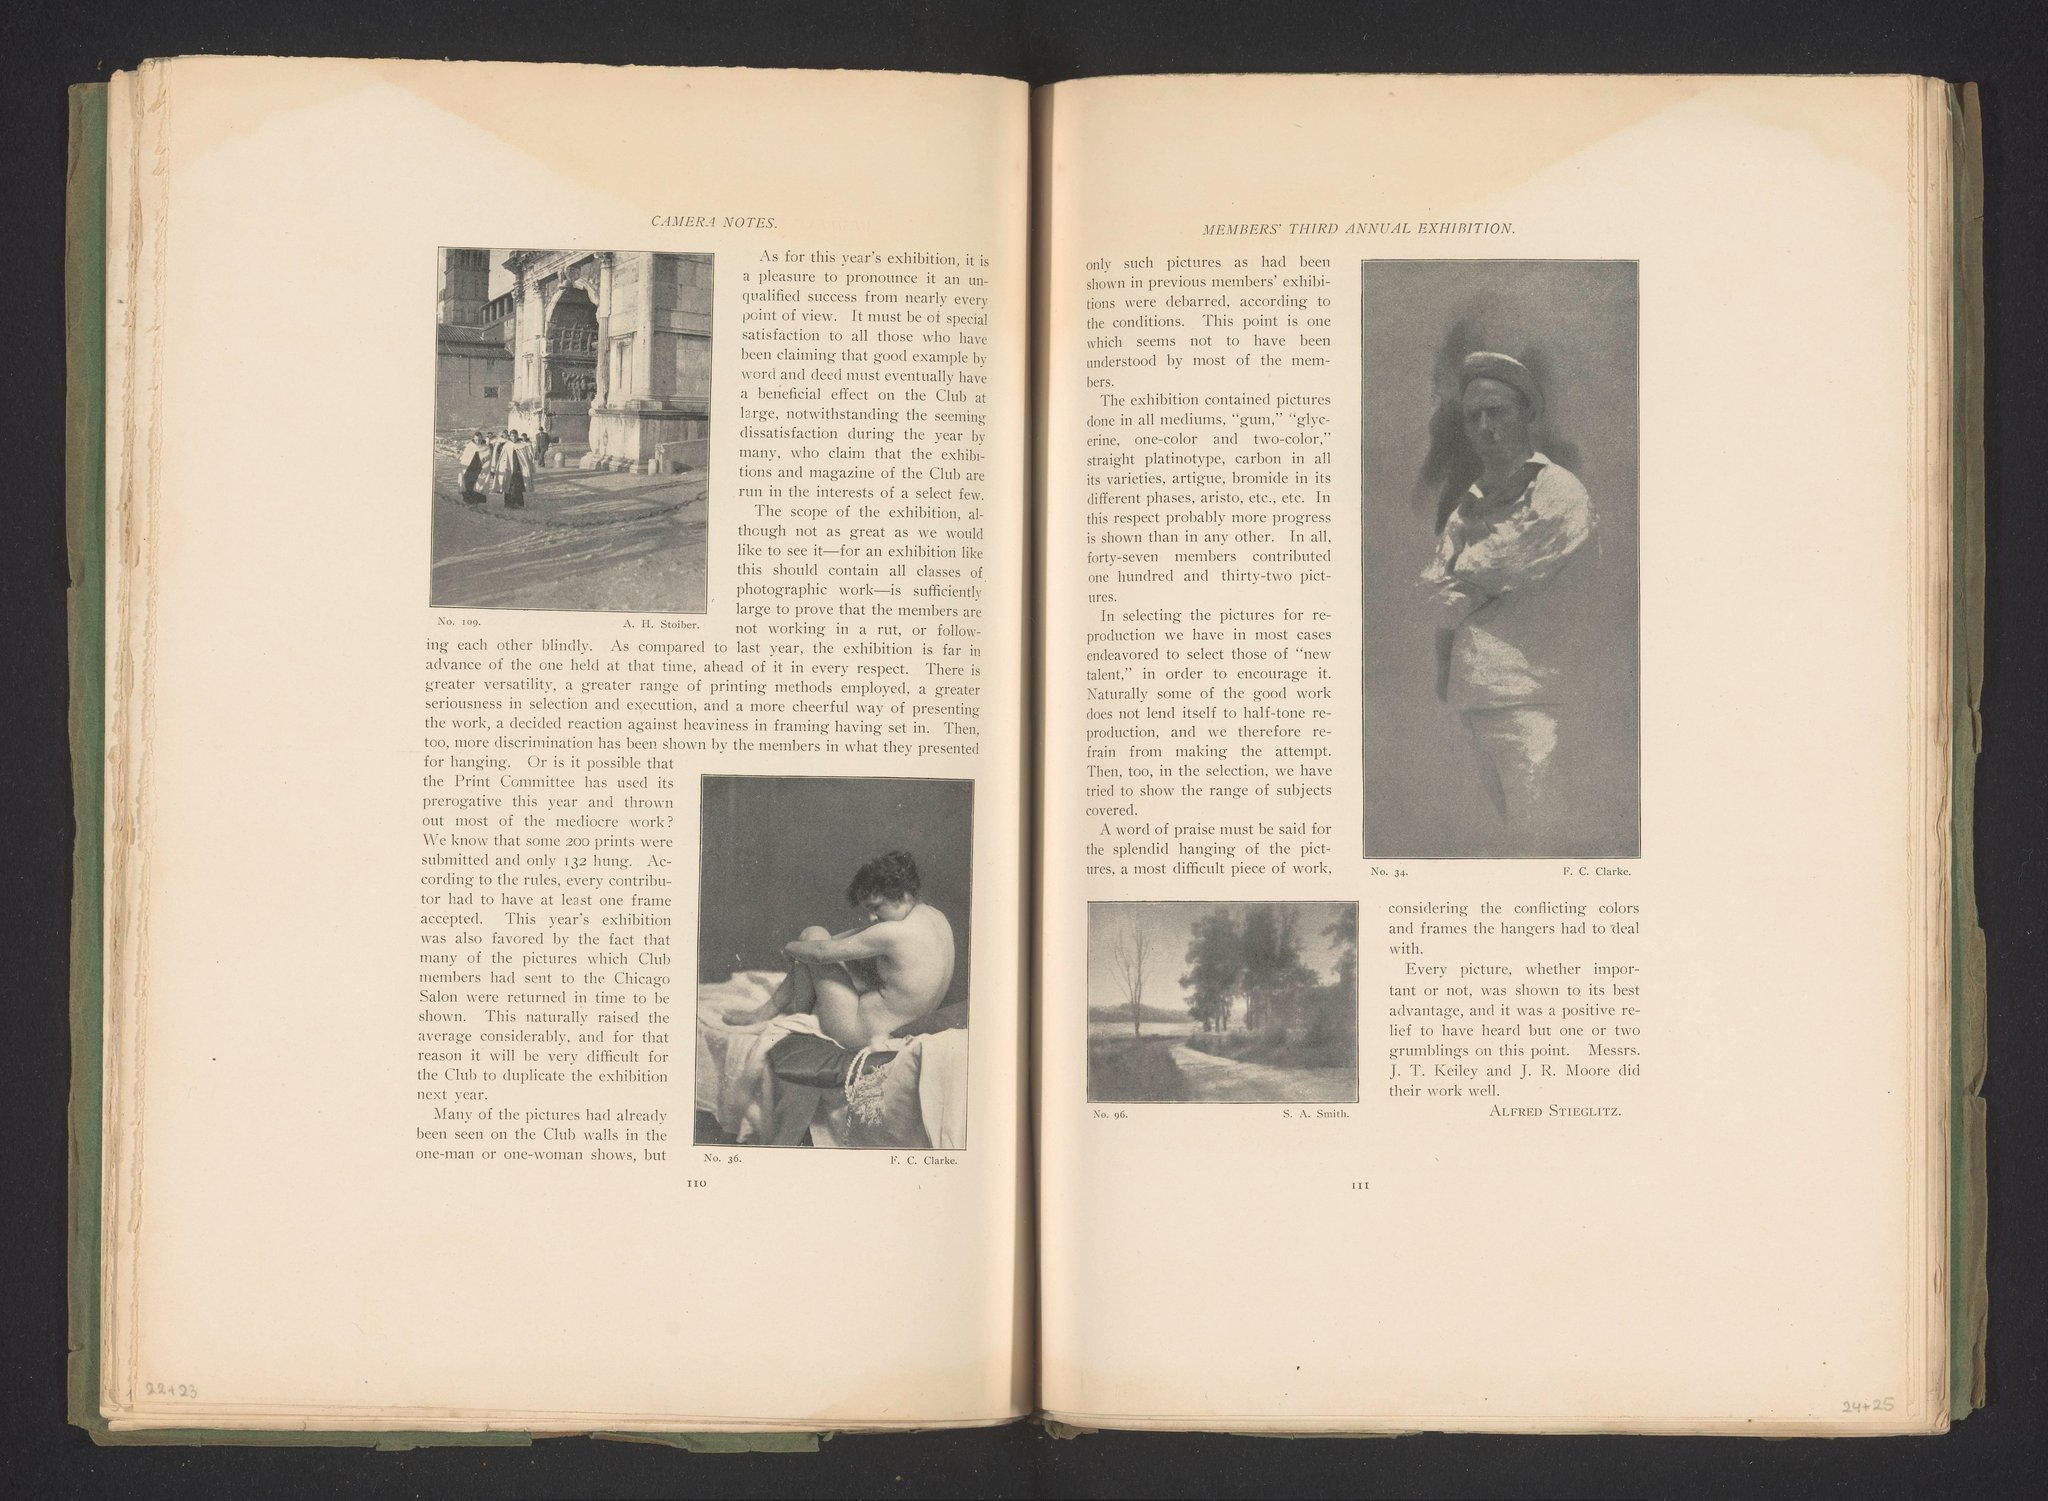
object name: page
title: Landschap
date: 1895-1900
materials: paper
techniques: autotype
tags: trees, landscapes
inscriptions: number: ‘No. 96’